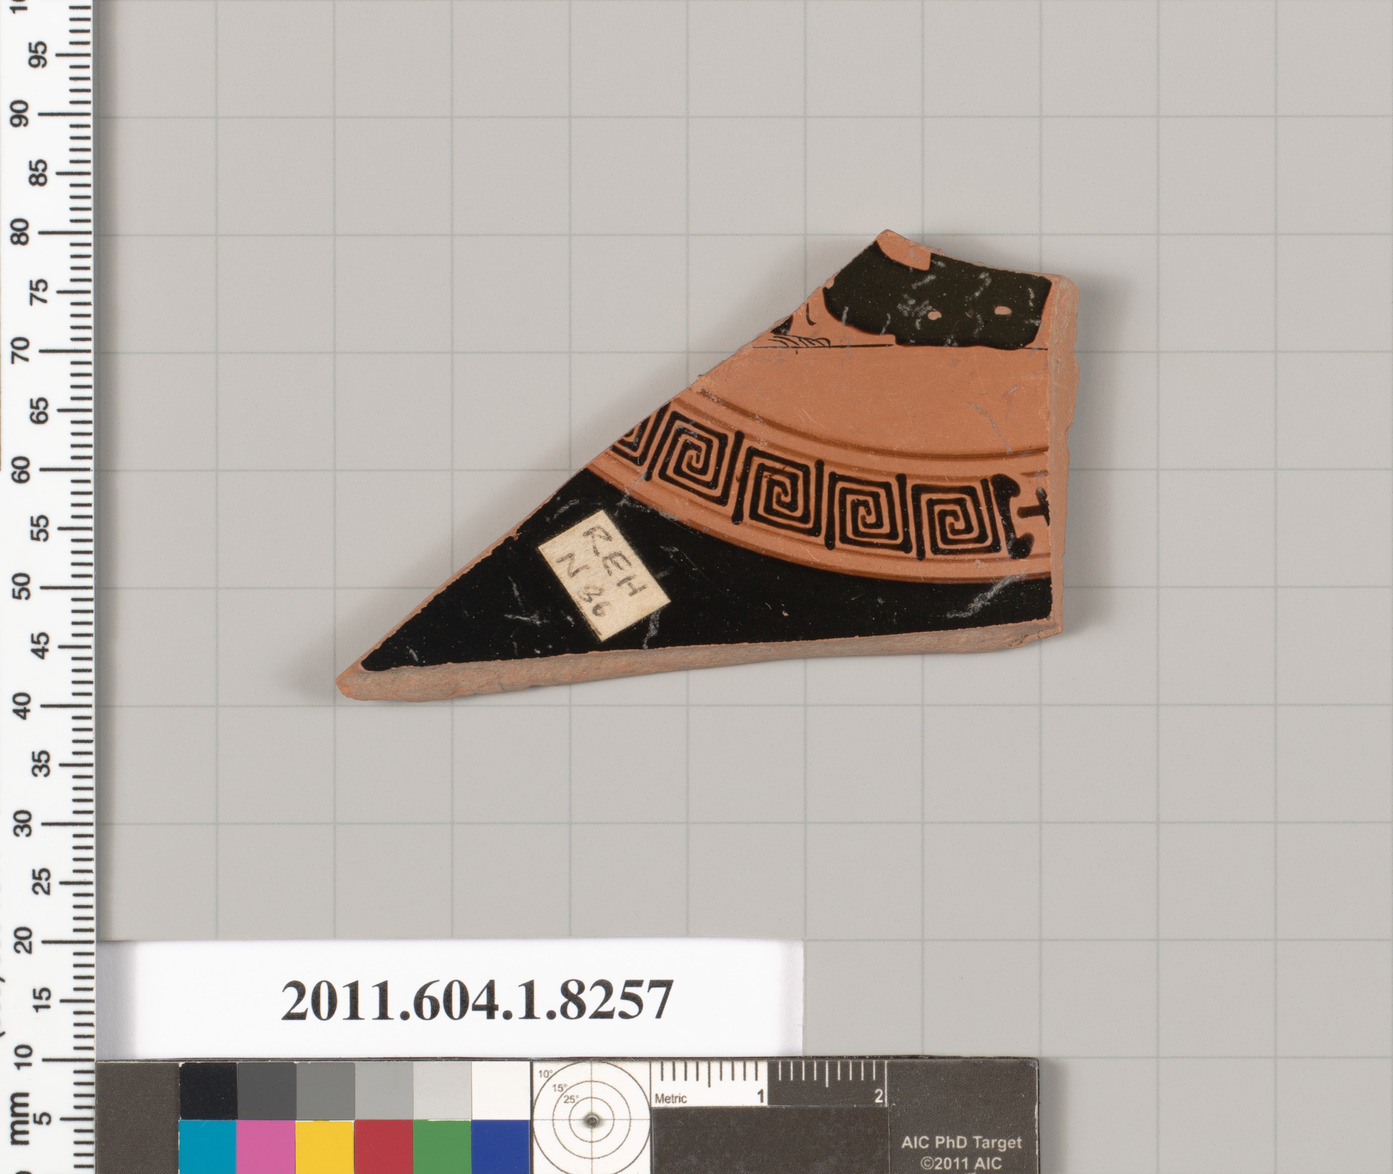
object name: kylix fragment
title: Terracotta fragment of a kylix (drinking cup)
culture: greek, attic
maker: akestorides painter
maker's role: artist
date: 475-451 BCE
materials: terracotta